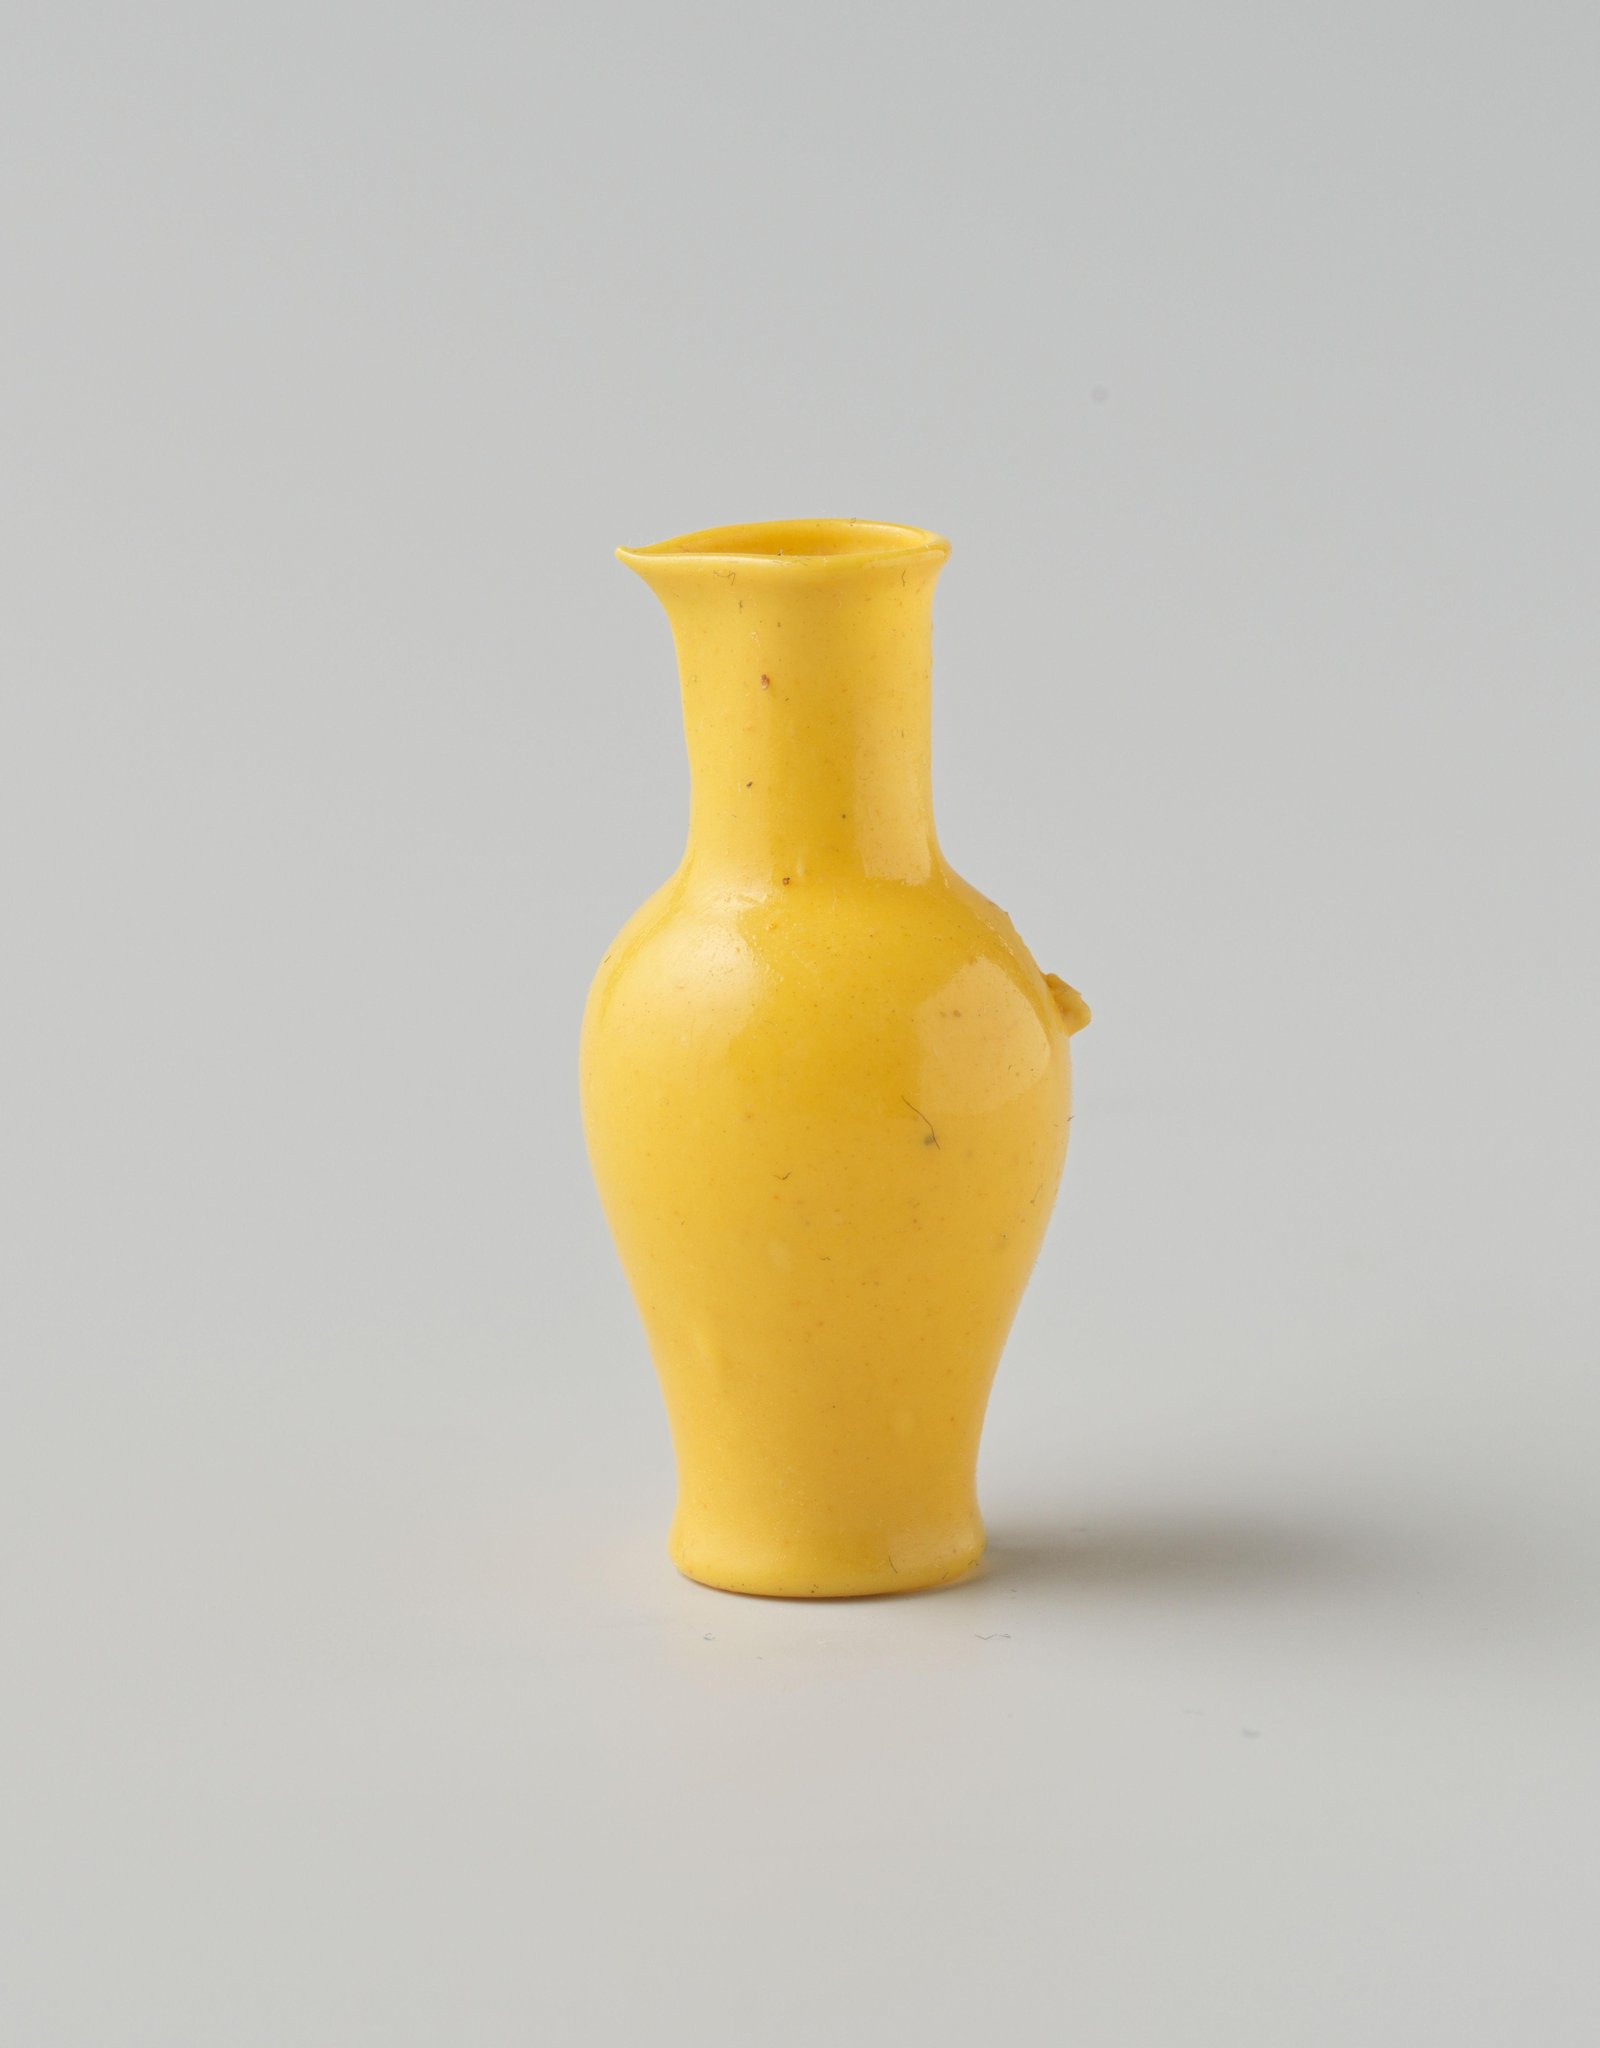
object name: miniature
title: Kan van opaak geel glas (waarschijnlijk imitatie geel aardwerk); bol en slank model met schenklip, aangezet oor en naar binnen gestoken bodem.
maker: Anonymous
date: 1675-1710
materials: glass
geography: amsterdam